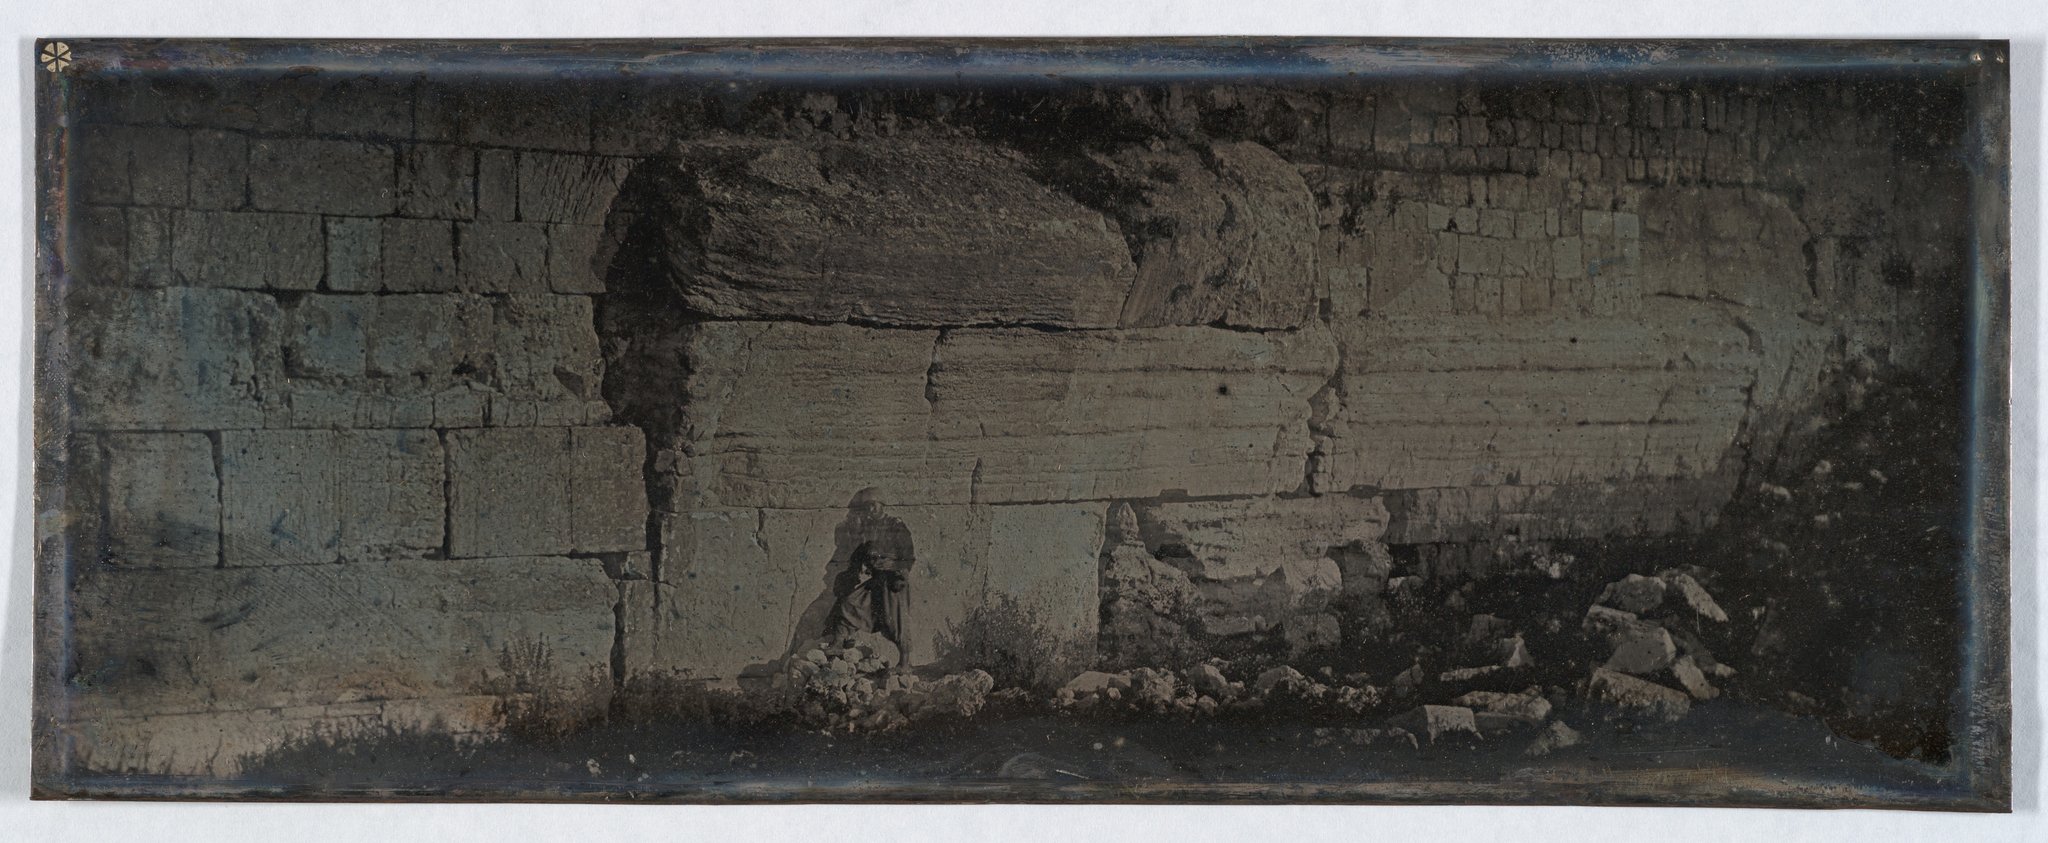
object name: photograph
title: Robinson's Arch, Jerusalem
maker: joseph-philibert girault de prangey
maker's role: artist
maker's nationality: french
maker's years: 1804-1892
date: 1844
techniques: daguerreotype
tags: architecture